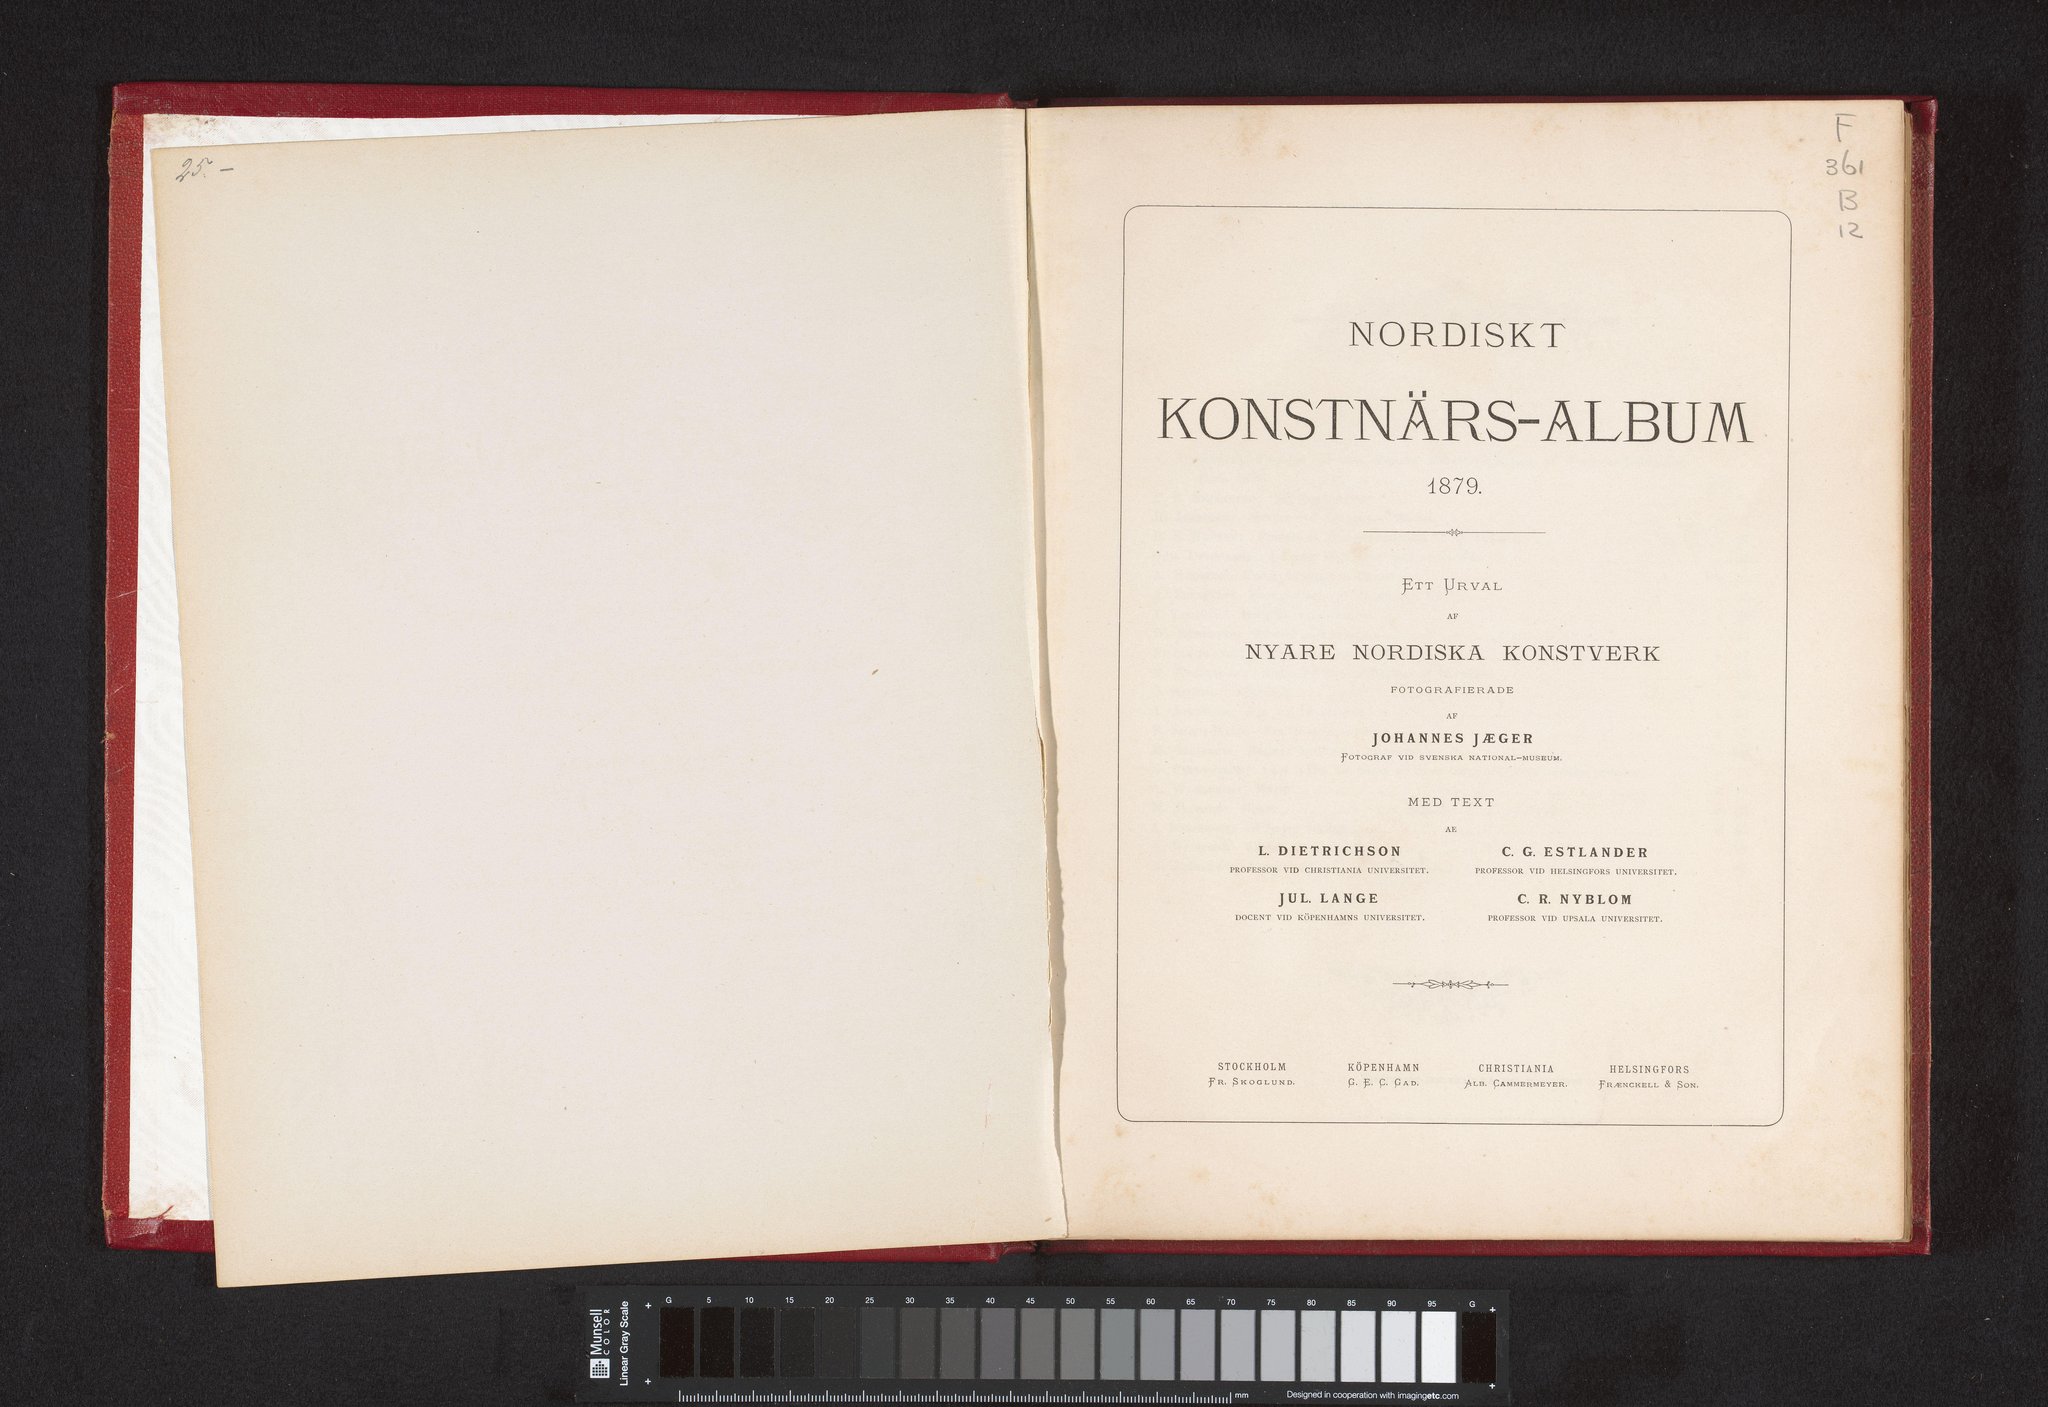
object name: book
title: Nordiskt konstnärs-album 1879 : ett urval af nyare nordiska konstverk / fotografierade af Johannes Jaeger; med text ae L. Dietrichson (...) [et al.]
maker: johannes jaeger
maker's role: fotograaf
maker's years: 1832-1908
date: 1879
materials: cardboard, linen, paper, photographic support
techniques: albumen print, printing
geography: scandinavia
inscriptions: date: ‘FEB/ 2003’